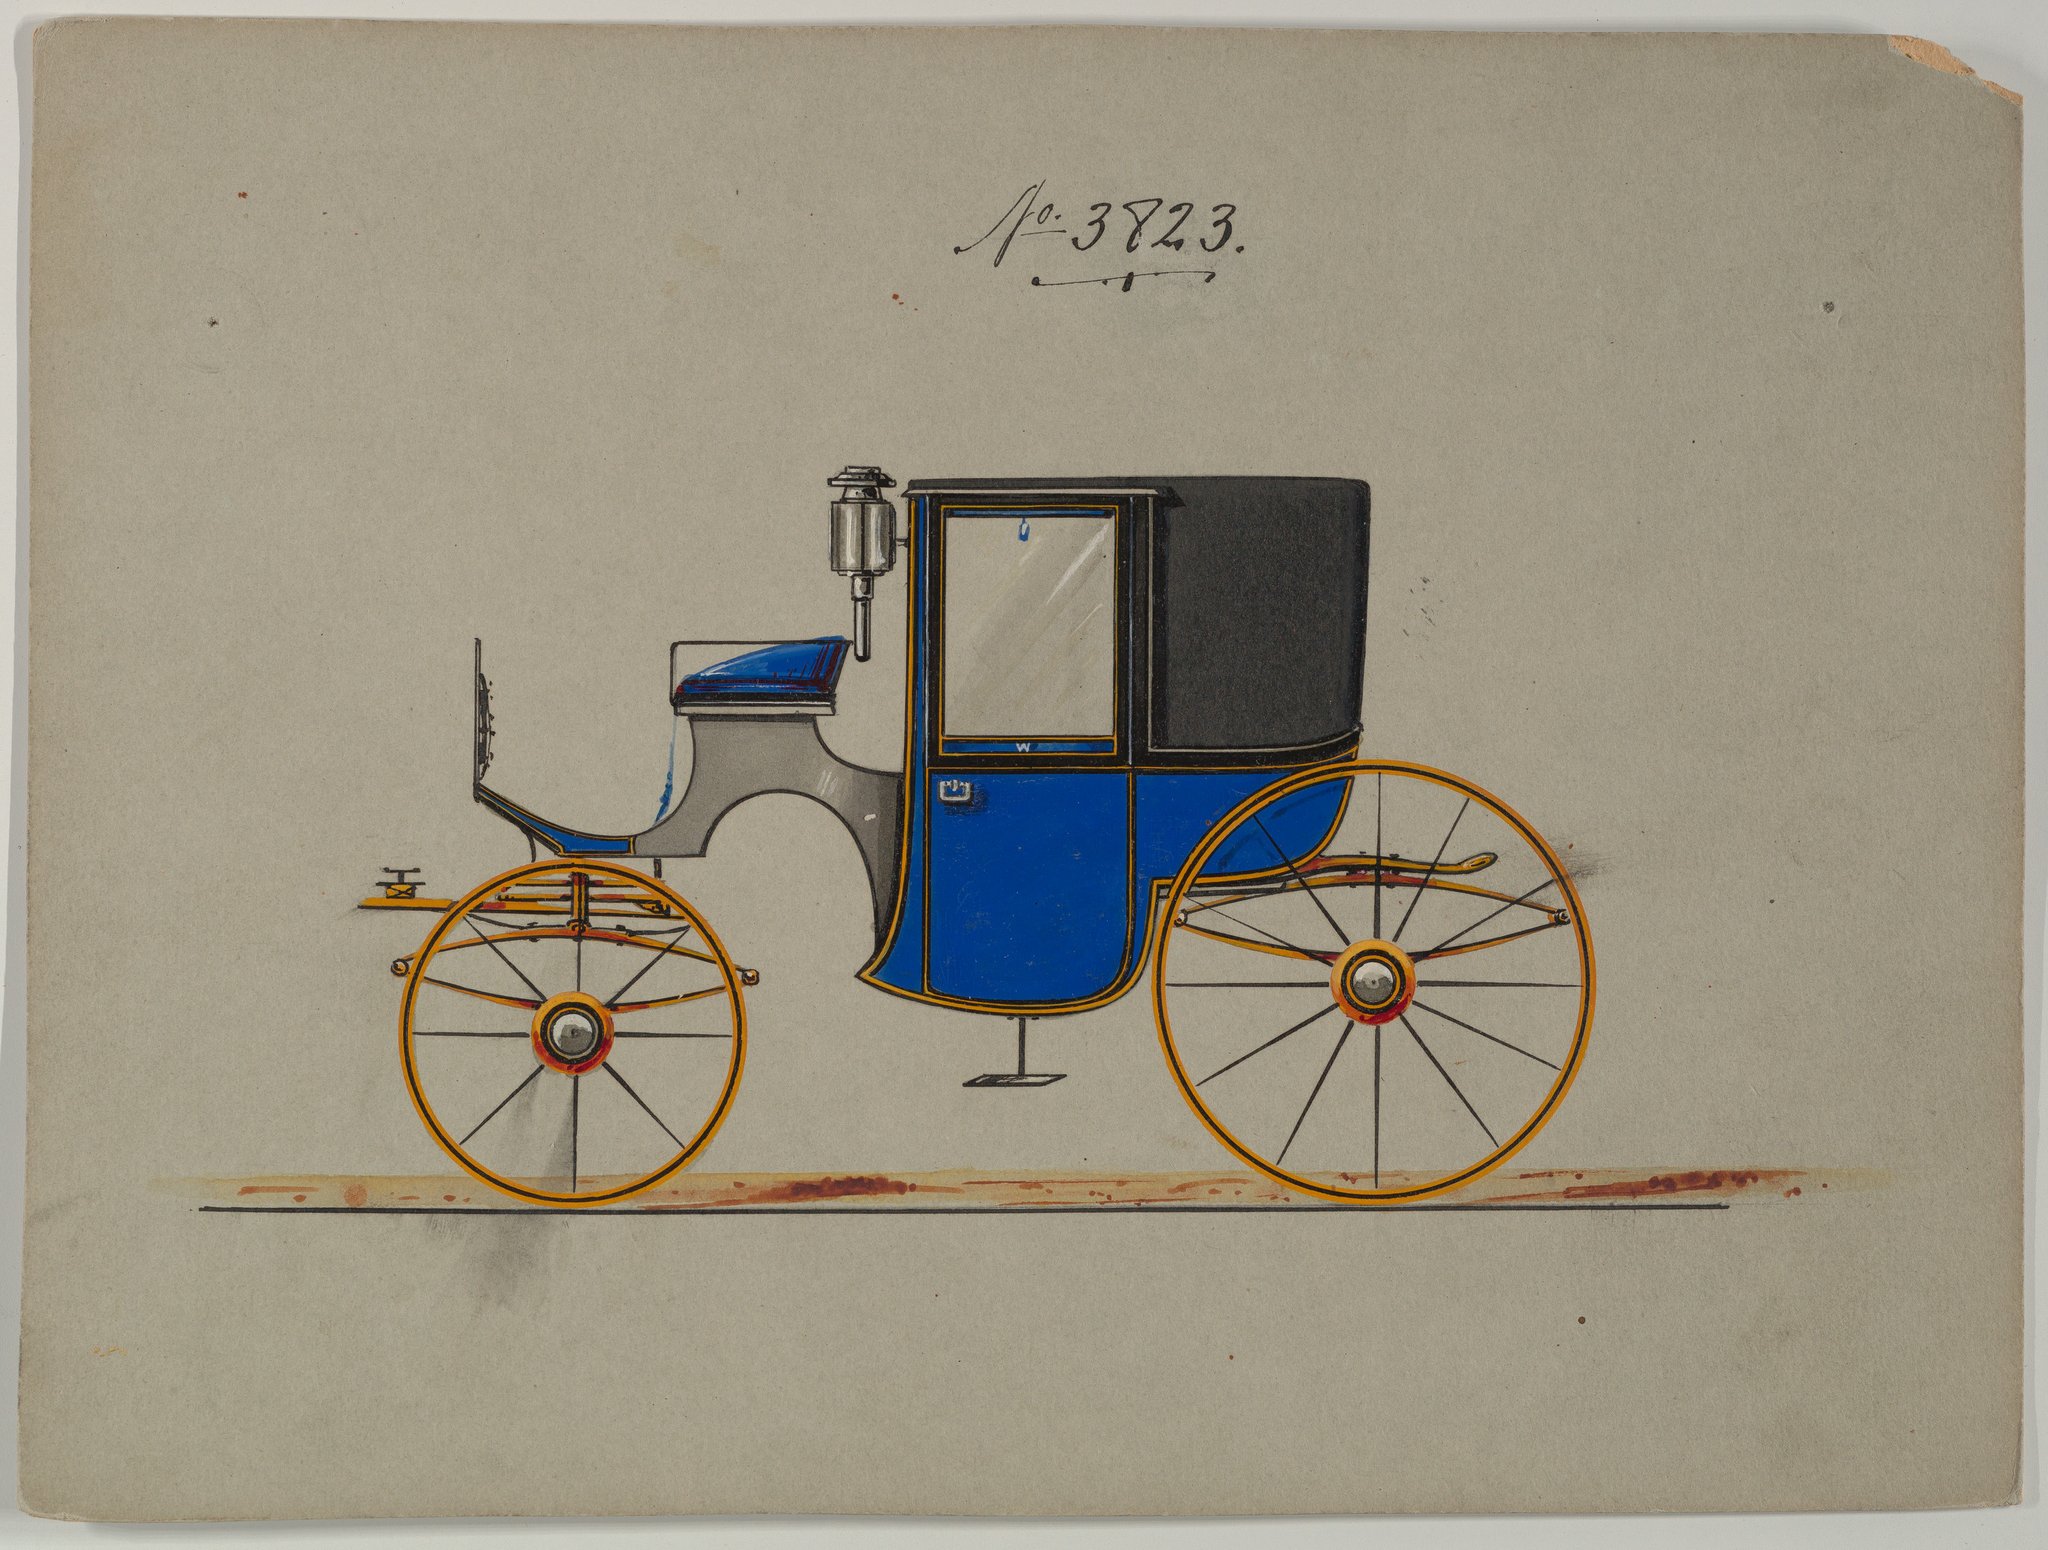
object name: drawing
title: Brougham #3823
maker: brewster & co.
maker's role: manufacturer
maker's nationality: american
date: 1883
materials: gouache, gum arabic, ink, watercolor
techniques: pen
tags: carriages